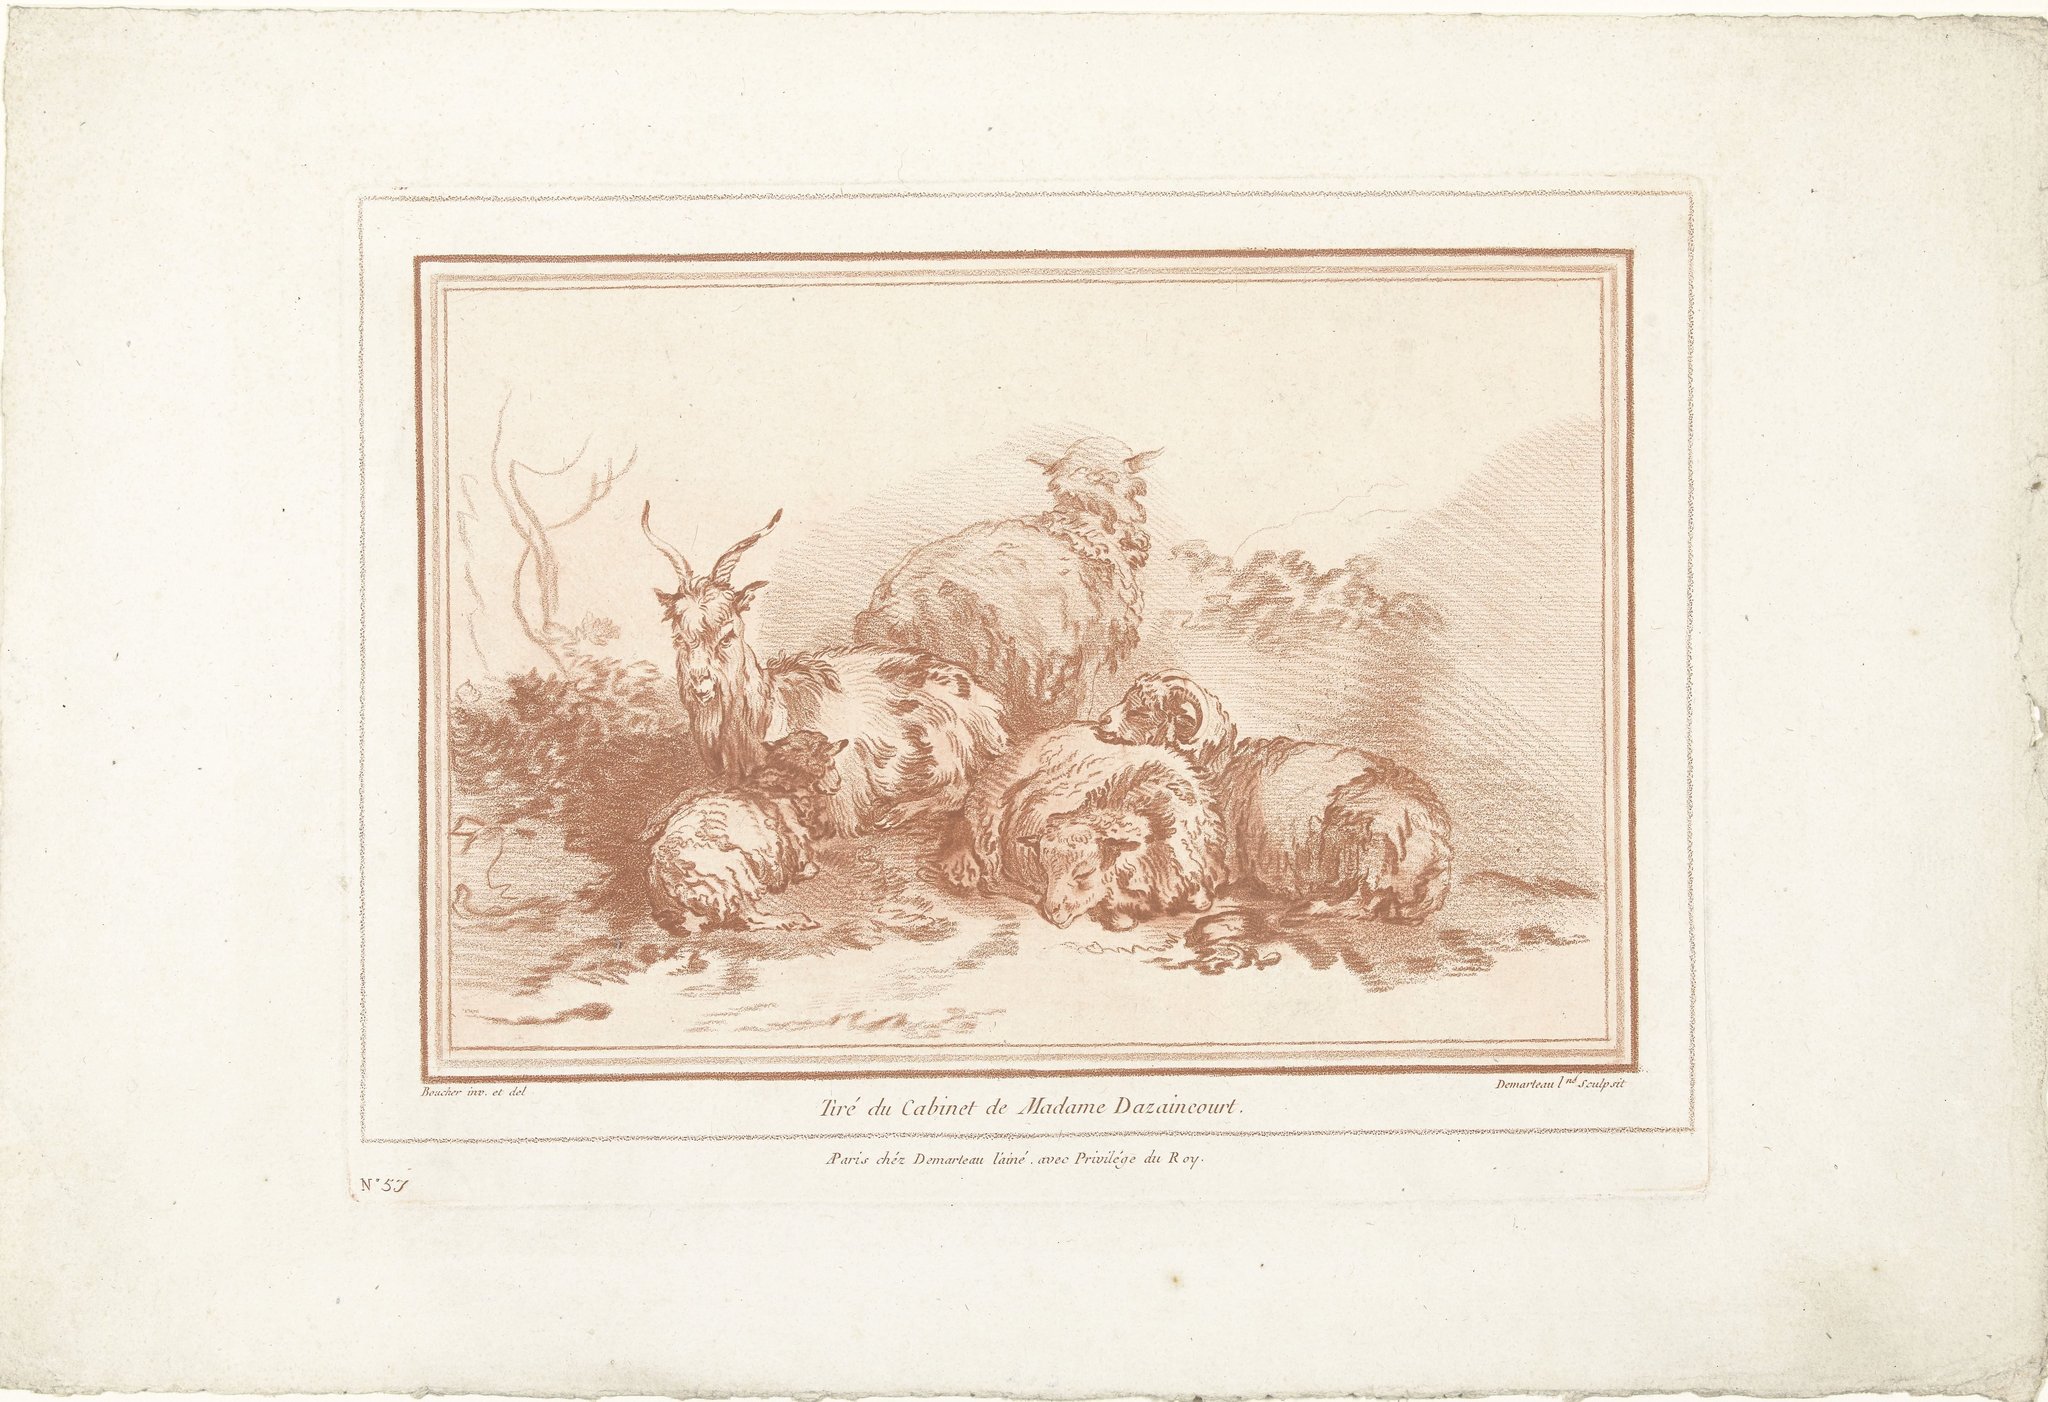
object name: print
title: Liggende schapen en geit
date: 1732-1776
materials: paper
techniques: printmaking, etching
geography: paris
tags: sheep, goat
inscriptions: number: ‘No 57’, collector's mark: Lugt 2228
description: Prent naar tekening uit collectie van Mevrouw d'Azaincourt, aldus opschrift (geschreven als Dazaincourt).